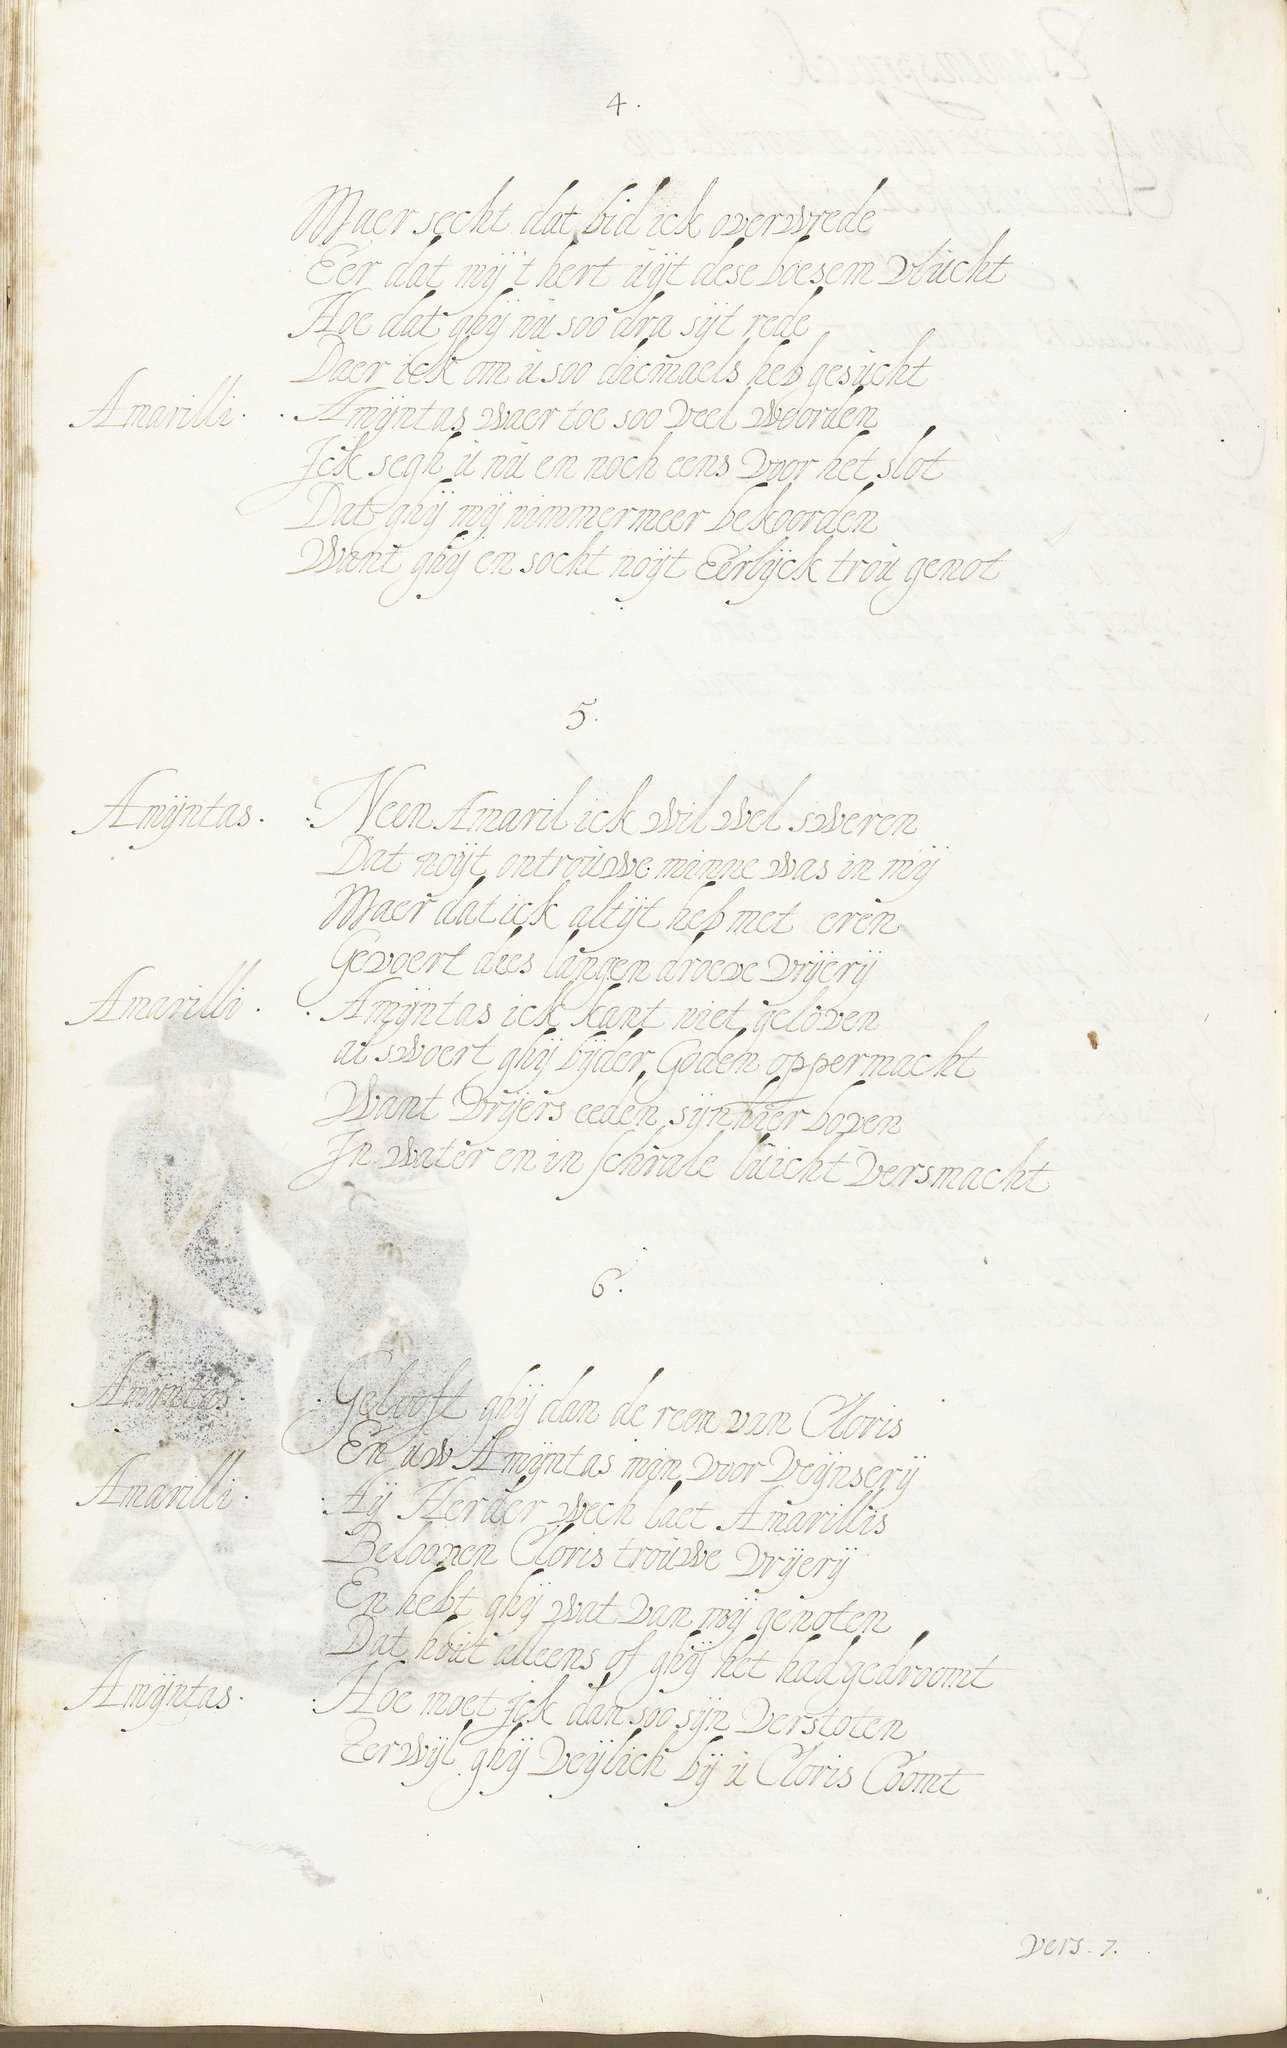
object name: calligraphy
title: Gedicht met dialoog tussen Amarilli en Amijntas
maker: gesina ter borch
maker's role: draughtsman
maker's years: 1633-1690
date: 1654-1658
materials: ink, paper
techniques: calligraphy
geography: zwolle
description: Vervolg van gedicht op de voorzijde van het blad met dialoog tussen Amarilli en Amijntas, op de melodie van Cantselaers testament.